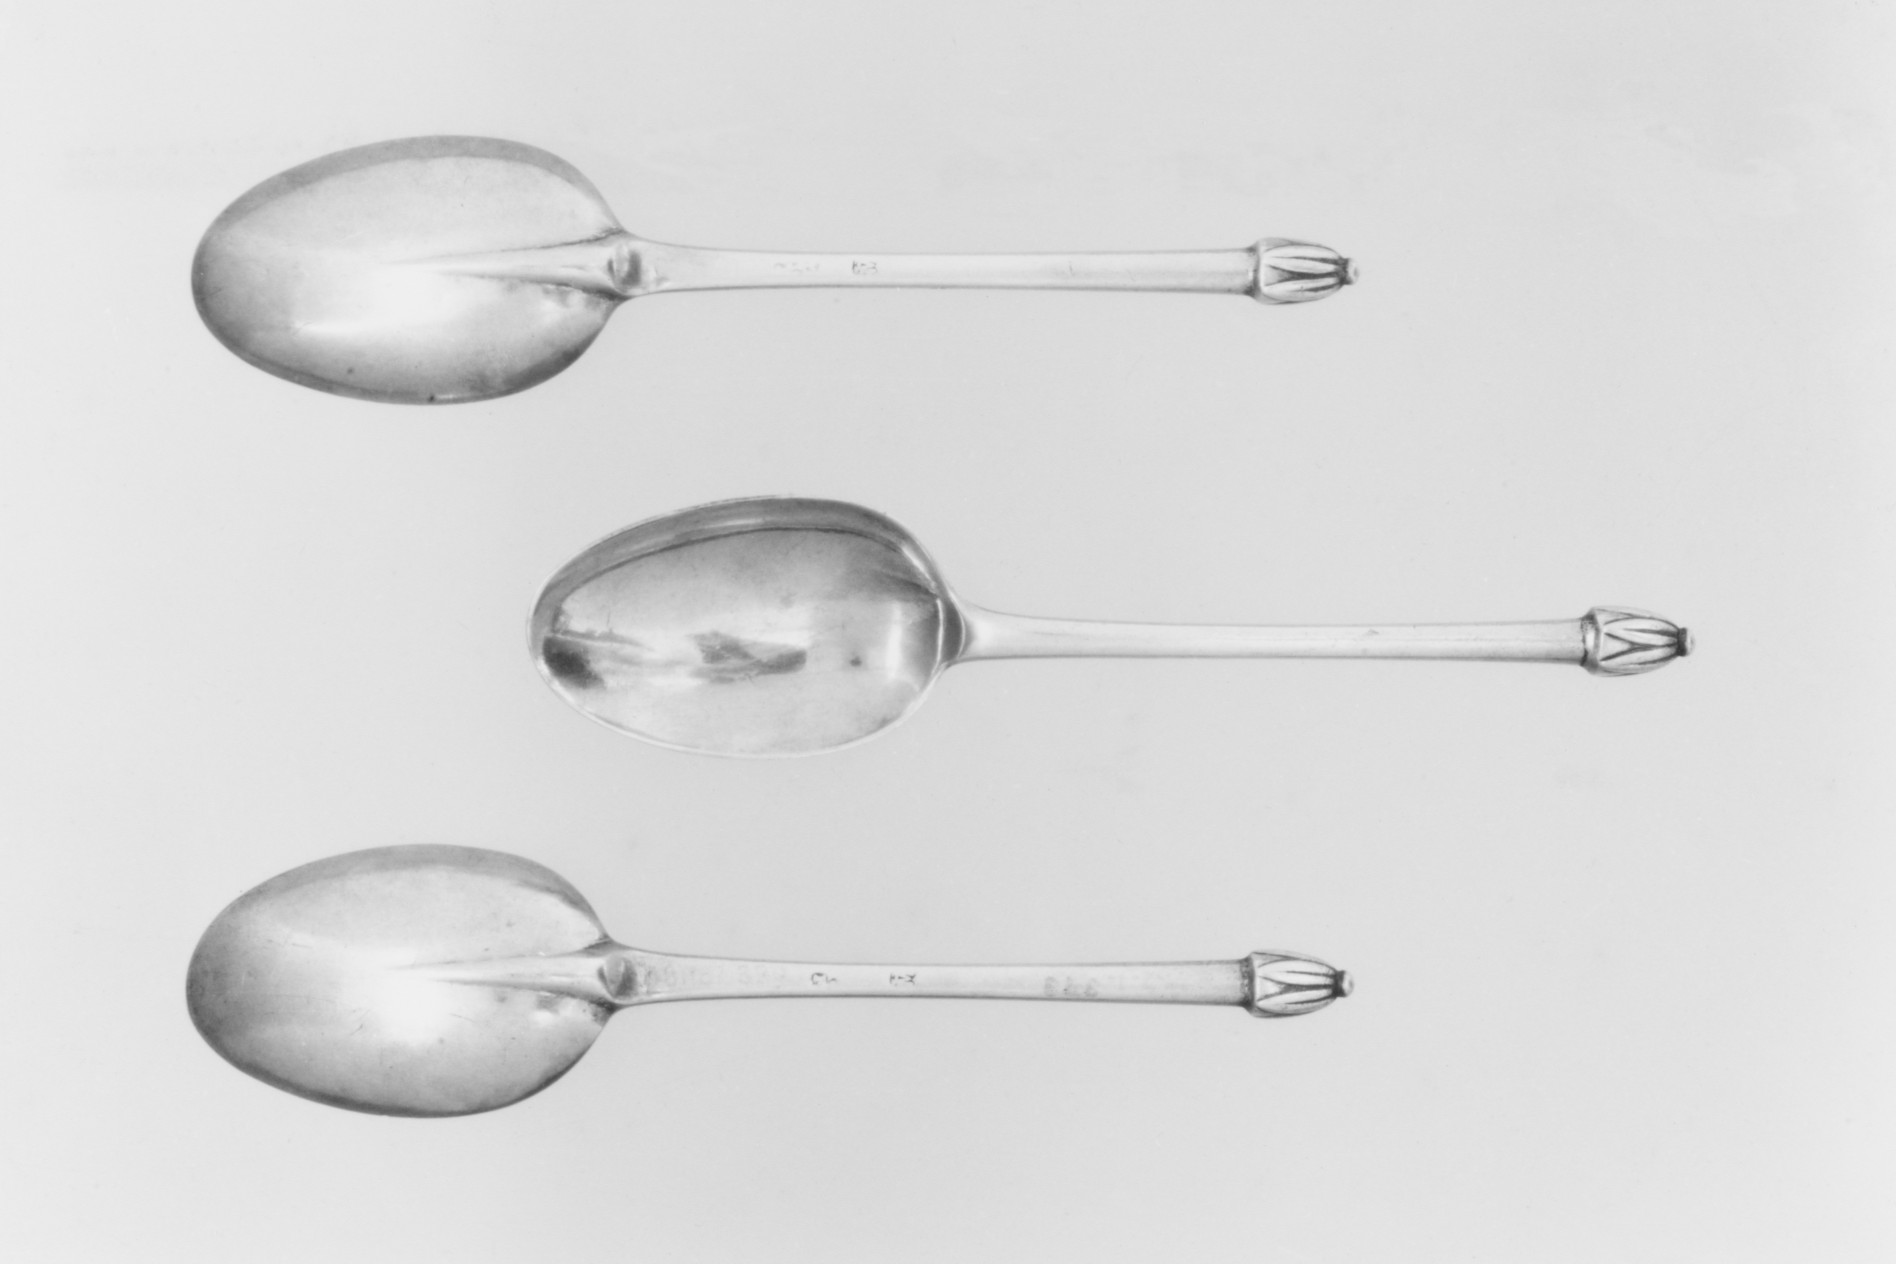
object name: spoon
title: Set of three spoons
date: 1691-1697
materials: gilt silver